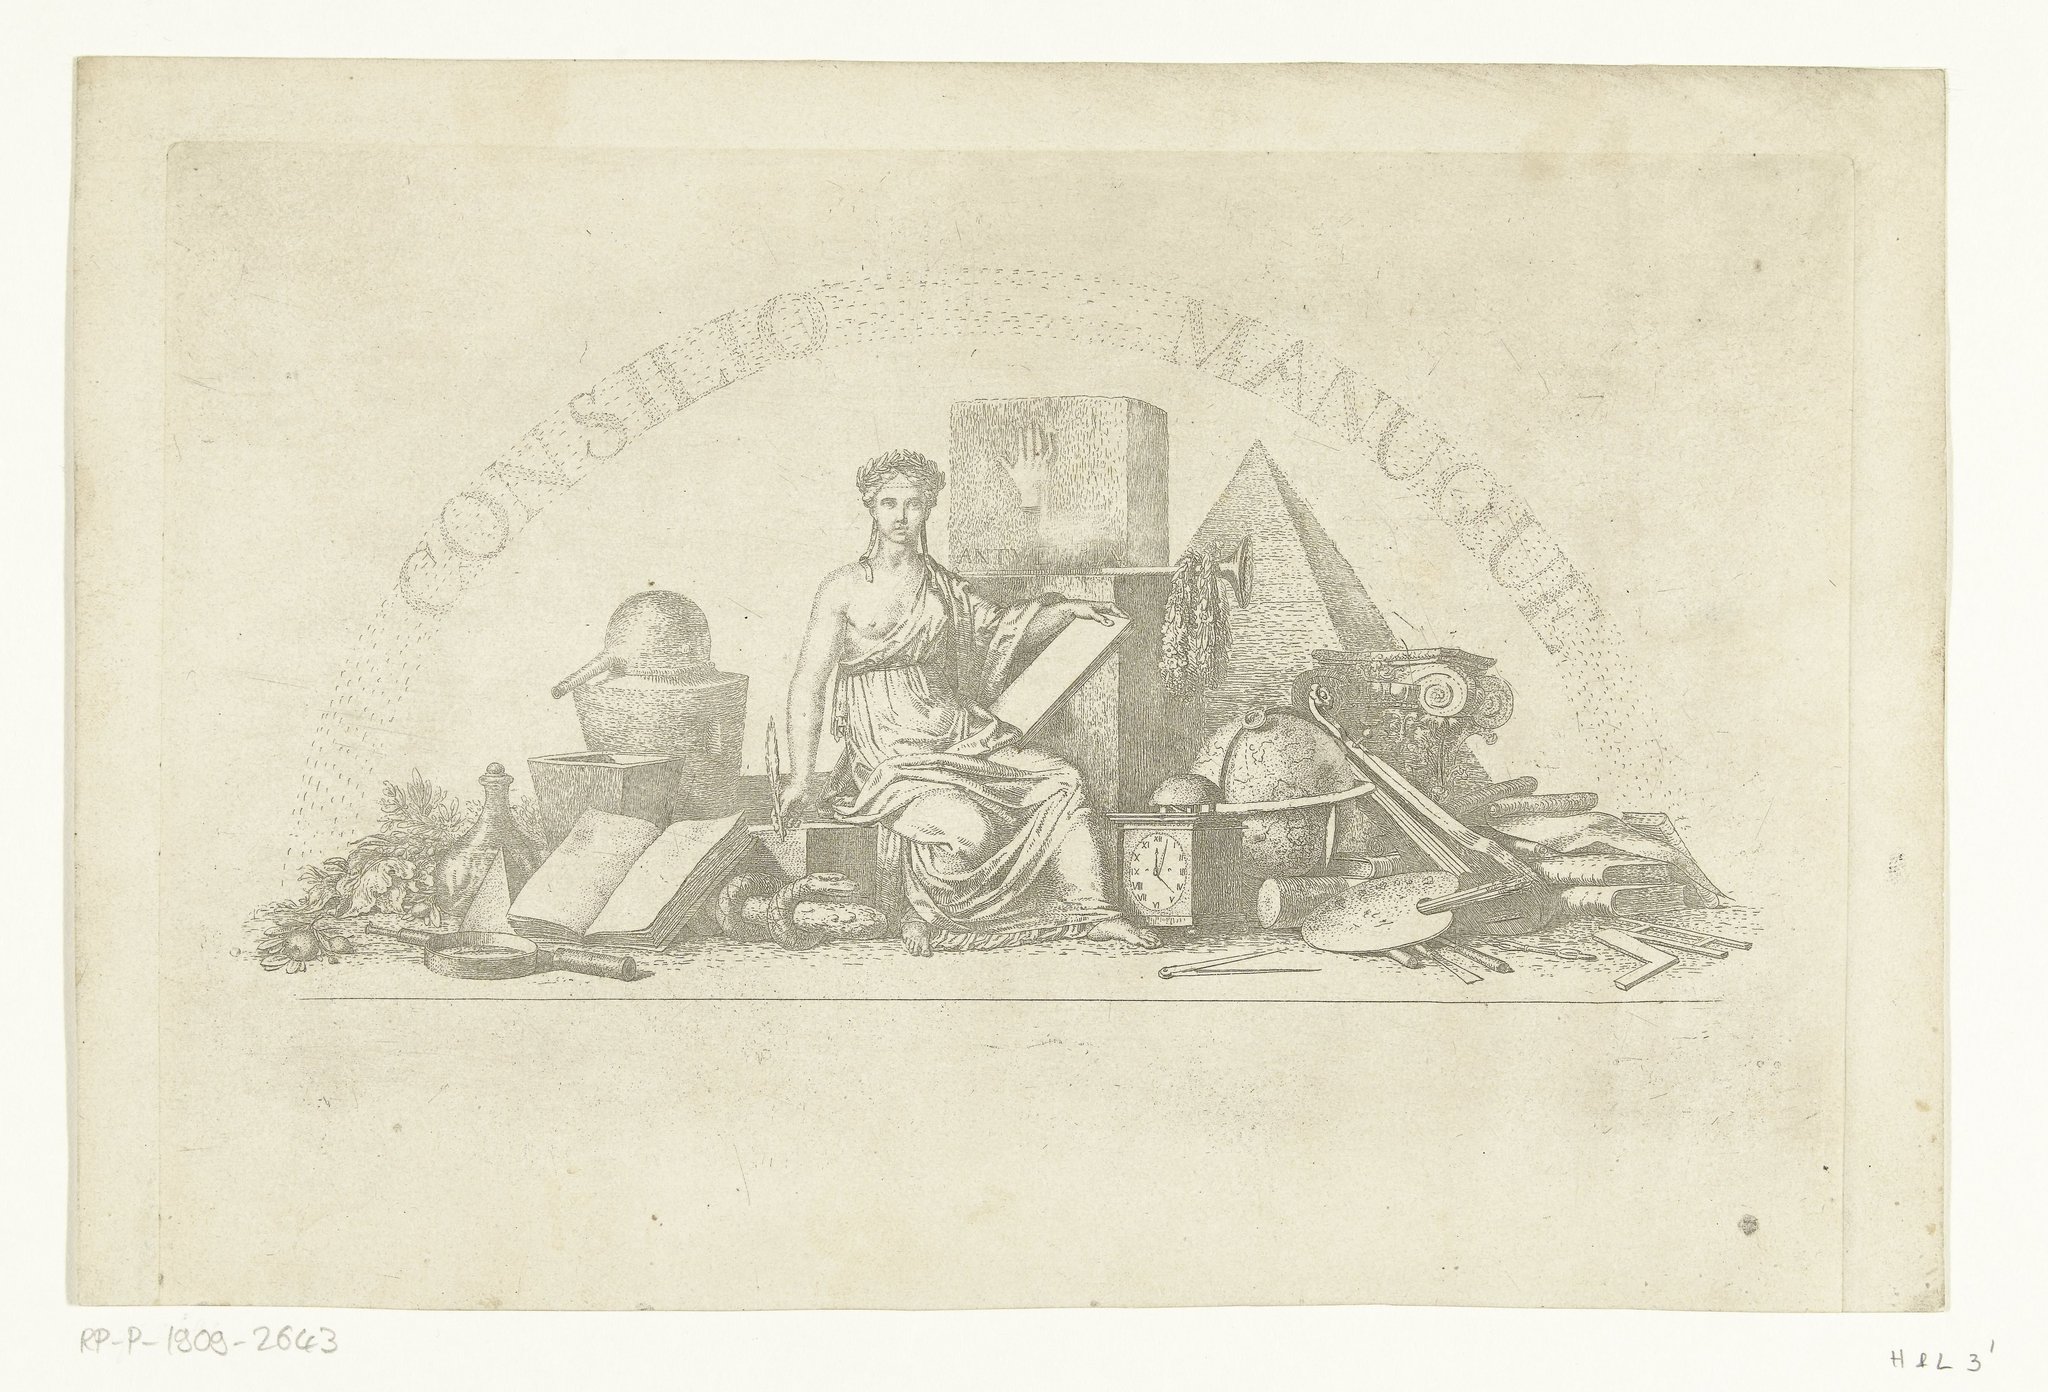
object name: print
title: Consilio manuque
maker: mattheus ignatius van bree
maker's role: draughtsman, print maker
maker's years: 1773-1839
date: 1804-1839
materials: paper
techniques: etching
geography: antwerp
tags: cities represented allegorically or symbolically, antwerp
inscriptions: collector's mark: Lugt 2228, collector's mark: Lugt 1485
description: Een allegorische figuur zit tussen symbolen voor kunst en wetenschappen. Achter haar op een steen is een hand gebeiteld en de naam van de stad Antwerpen. Op een halfronde boog het motto: Consilio manuque.